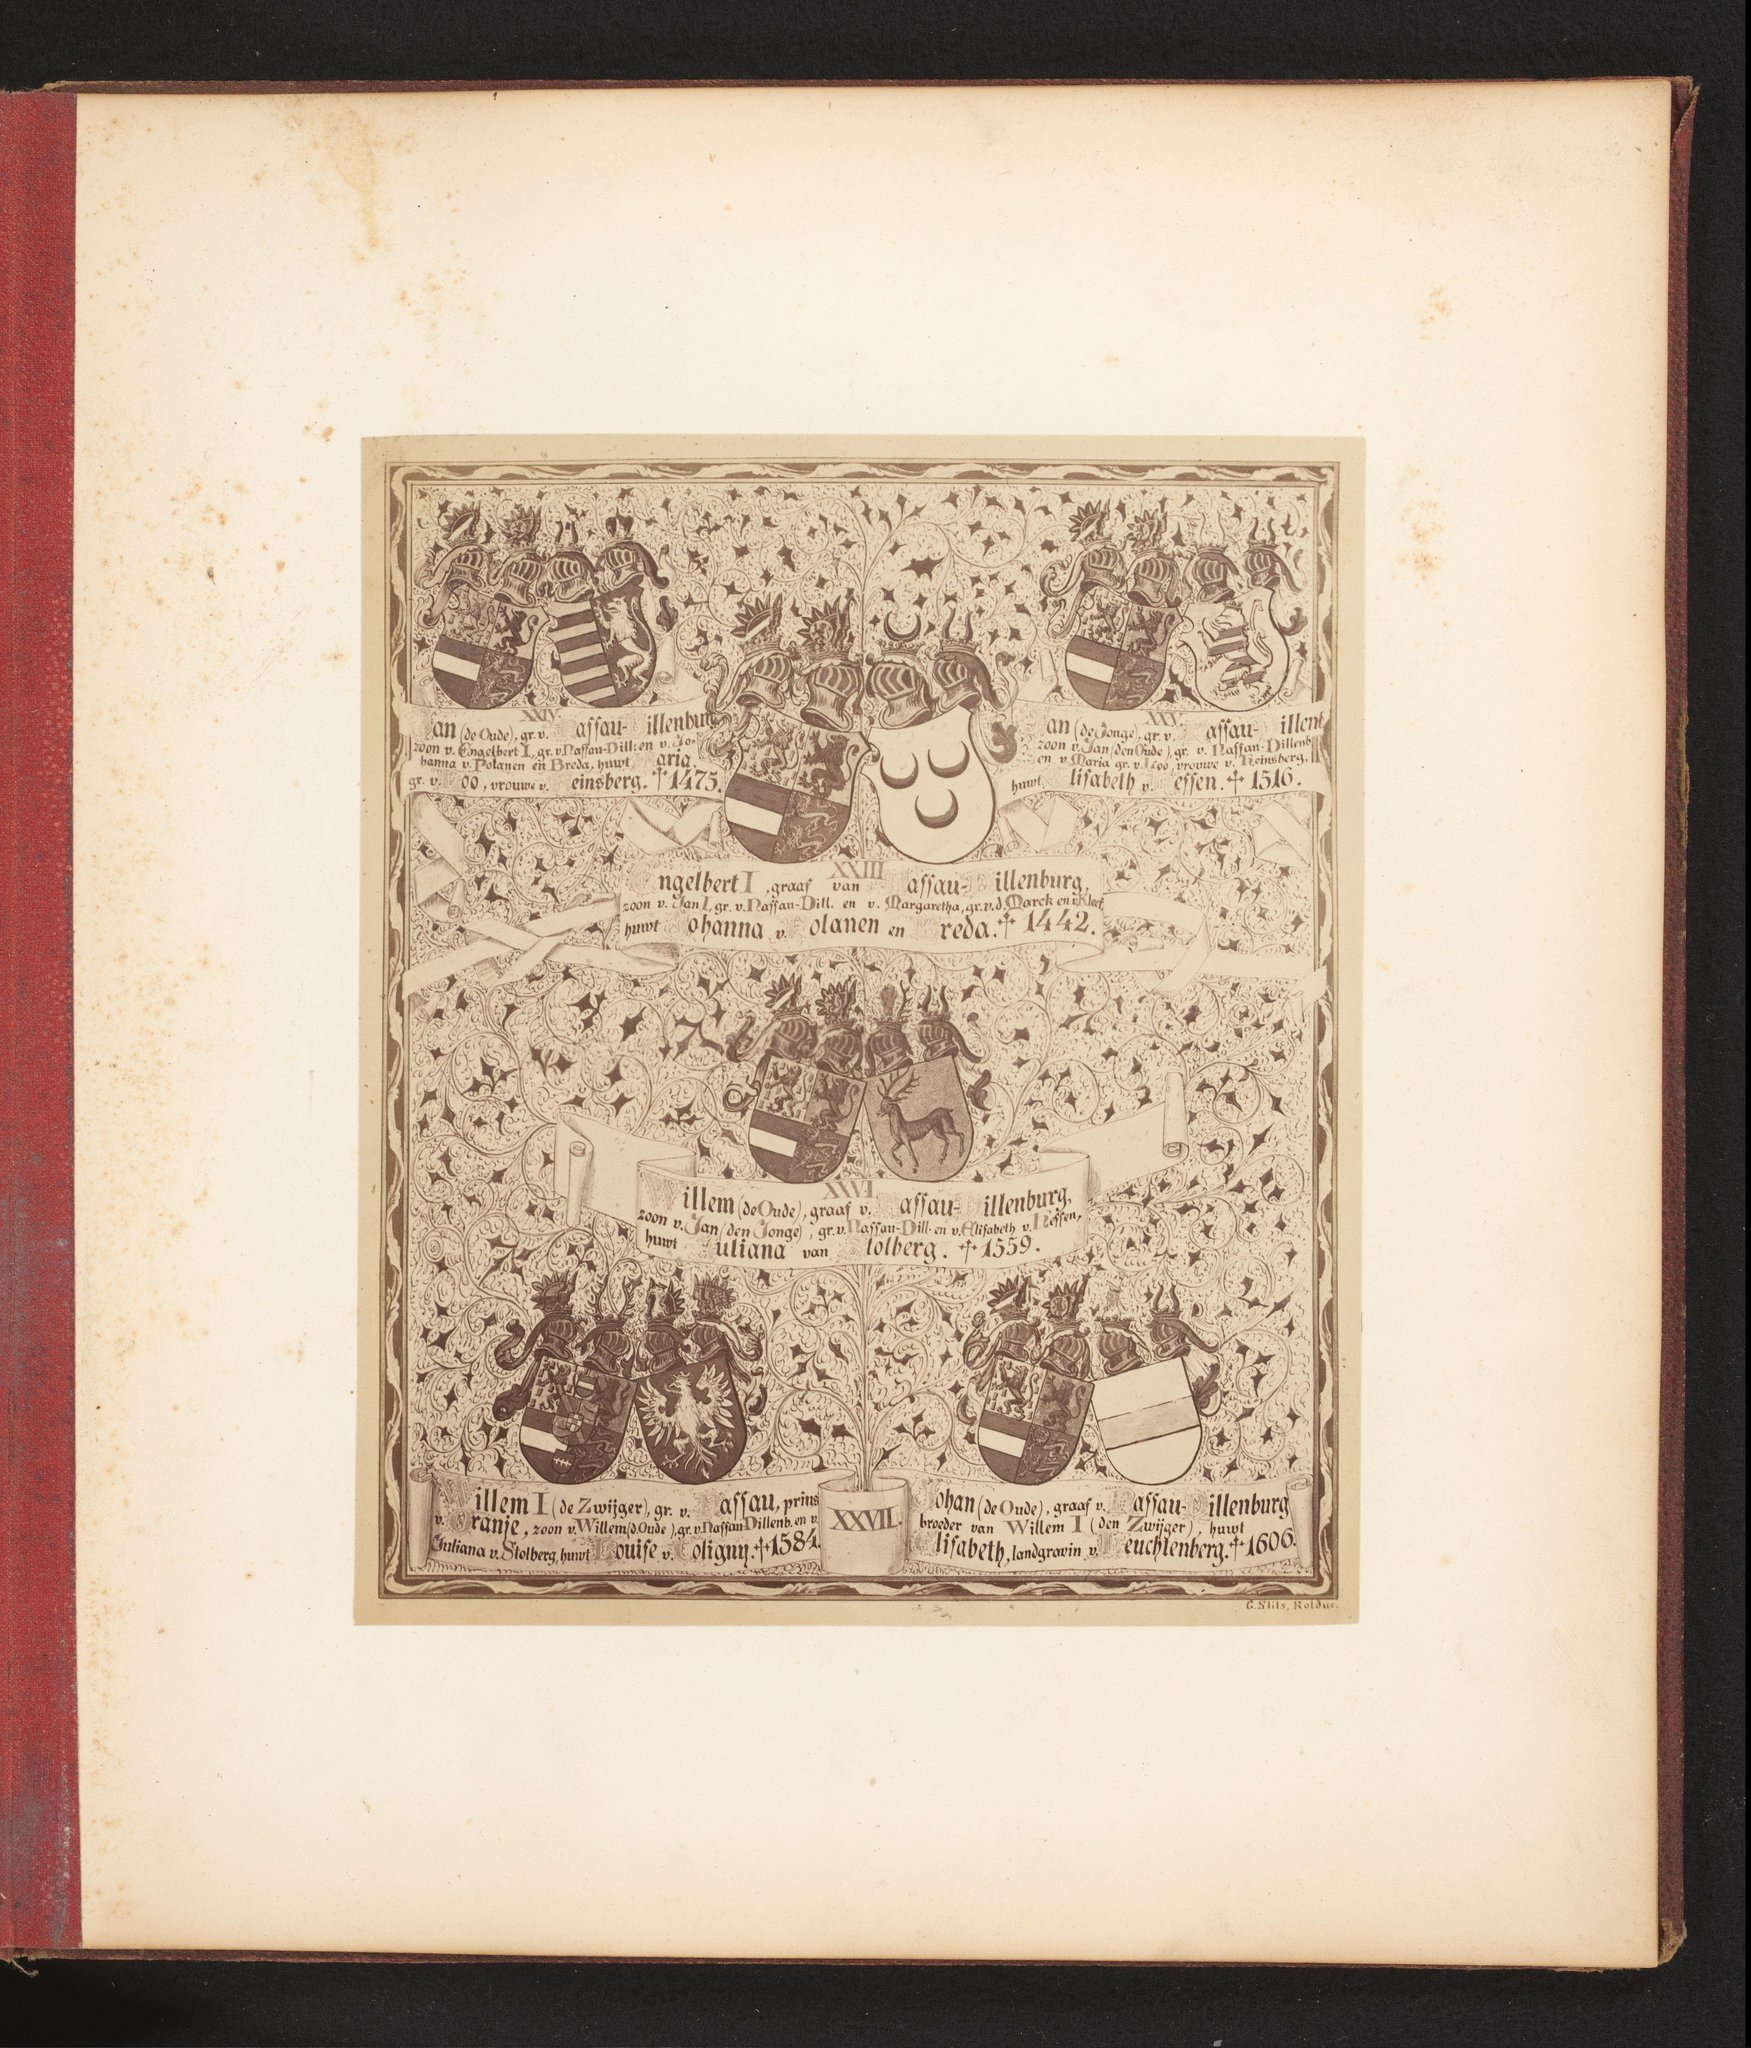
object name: reproduction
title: Fotoreproductie van een tekening van een stamboom, van Jan de Oude, graaf van Nassau-Dillenburg, tot Johan de Oude, graaf van Nassau-Dillenburg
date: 1869-1874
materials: cardboard, paper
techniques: albumen print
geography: rolduc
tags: delft, william i (prince of orange), earl, family lineage, pedigree, genealogical tree or table, series of rulers